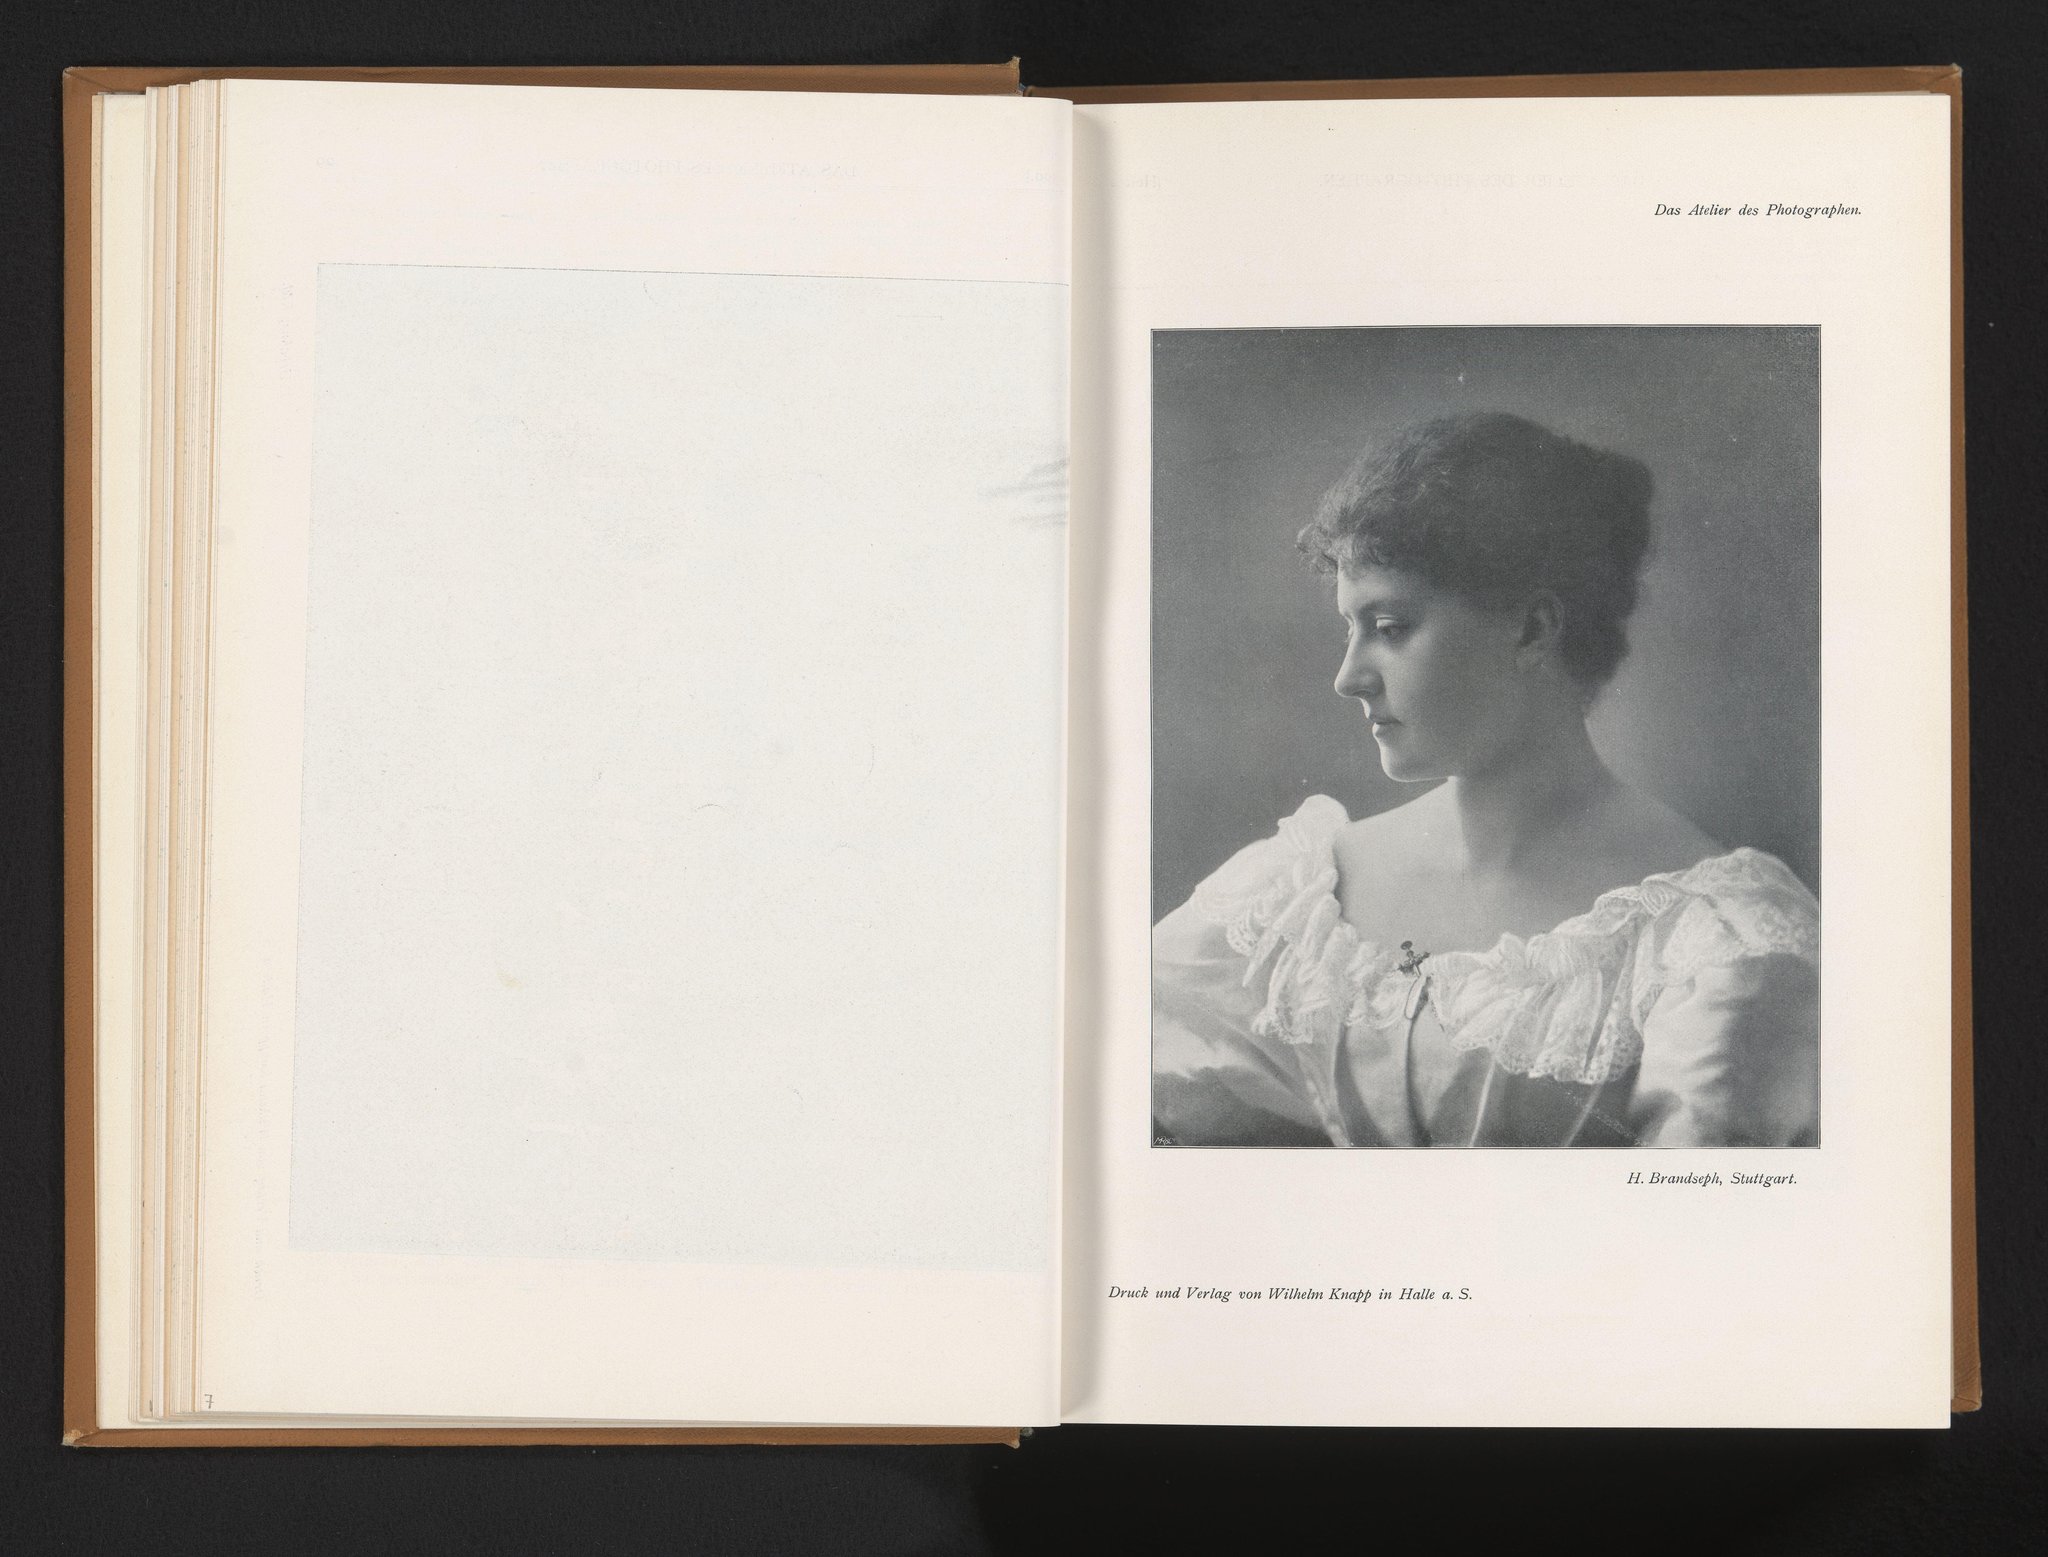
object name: photomechanical print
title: Portret van een onbekende vrouw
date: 1895-1900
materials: paper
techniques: autotype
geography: halle an der saale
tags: historical persons - bb - woman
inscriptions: inscription: ‘Das Atelier des Photographen.’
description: Prent op derde ongenummerde pagina na pagina 28.